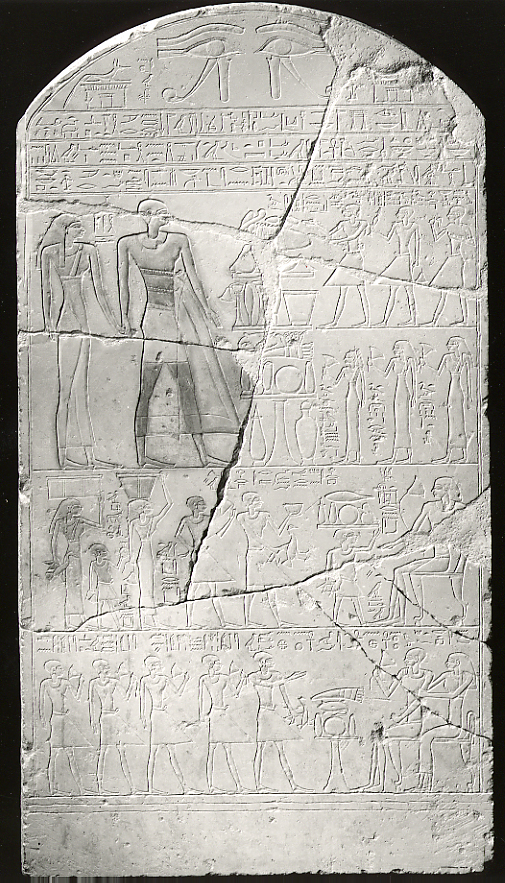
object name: stela, reniseneb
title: Stela of Reniseneb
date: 1765-1763 BCE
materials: limestone, paint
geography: northern upper egypt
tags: men,women,hieroglyphs